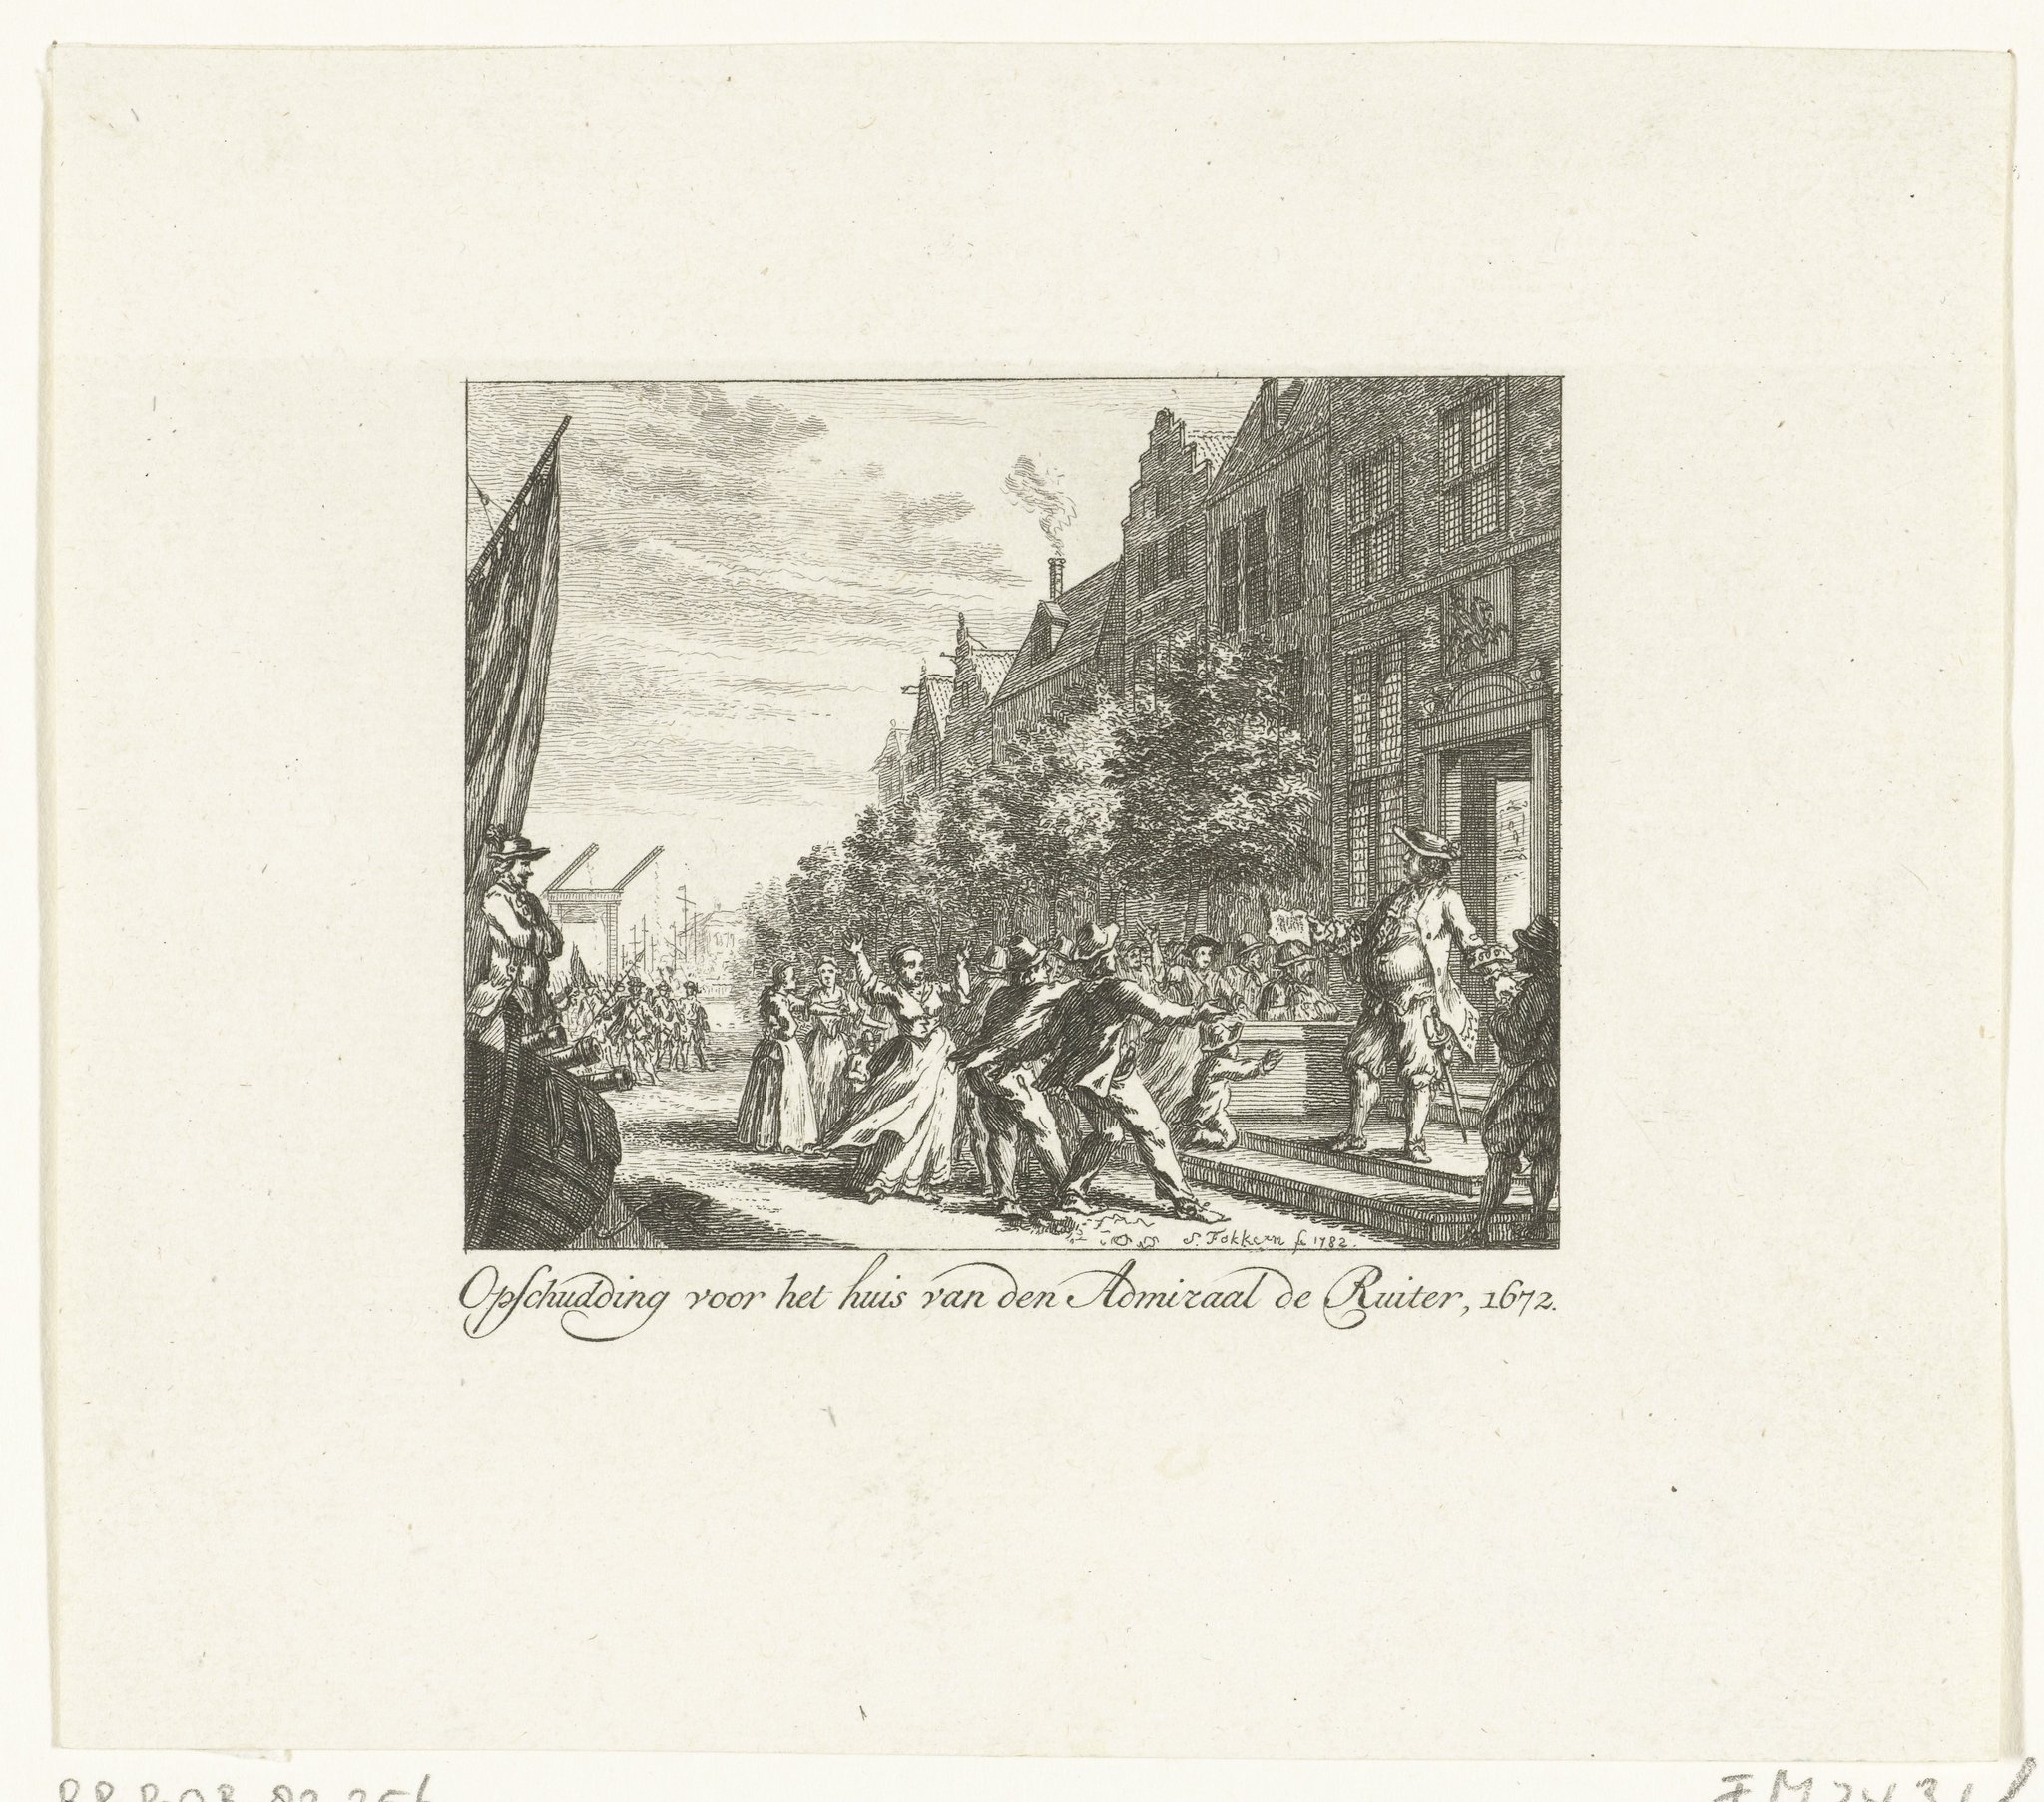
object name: history print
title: Opstootje voor het huis van admiraal De Ruyter, 1672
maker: simon fokke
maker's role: draughtsman, print maker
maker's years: 1712-1784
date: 1782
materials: paper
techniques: etching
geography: northern netherlands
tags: flushing, michiel adriaenszoon de ruyter, street-fights, riots, amsterdam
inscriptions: date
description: Woedende menigte voor het huis van admiraal Michiel Adriaenszoon de Ruyter aan de Prins Hendrikkade te Amsterdam. Hij werd valselijk beschuldigd de vloot aan de Fransen te willen verraden, 6 oktober 1672.